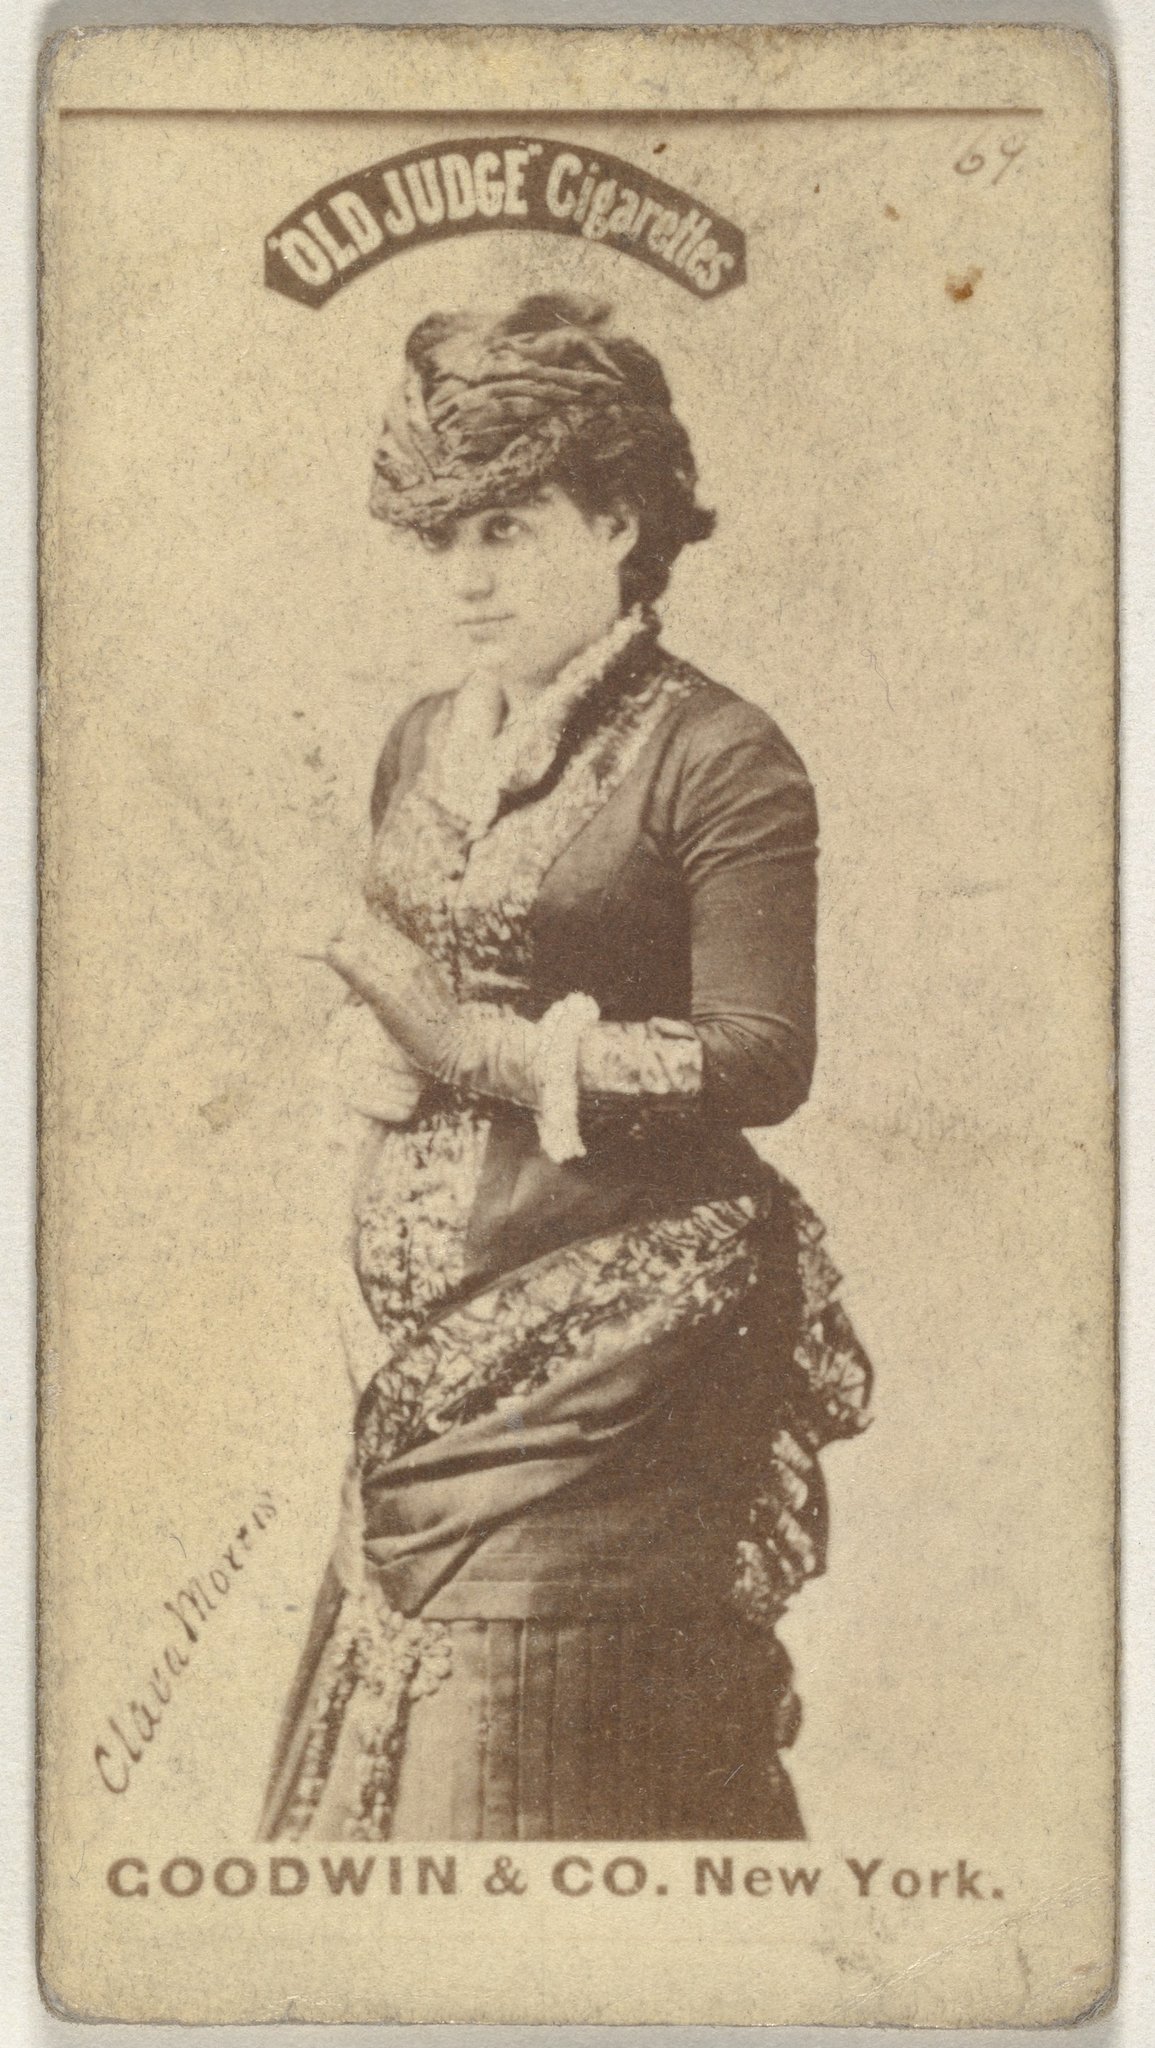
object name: photograph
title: Clara Morris, from the Actors and Actresses series (N171) for Old Judge Cigarettes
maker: goodwin & company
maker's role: publisher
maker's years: 1850-1950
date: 1886-1890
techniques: albumen silver print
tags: portraits,women,actresses